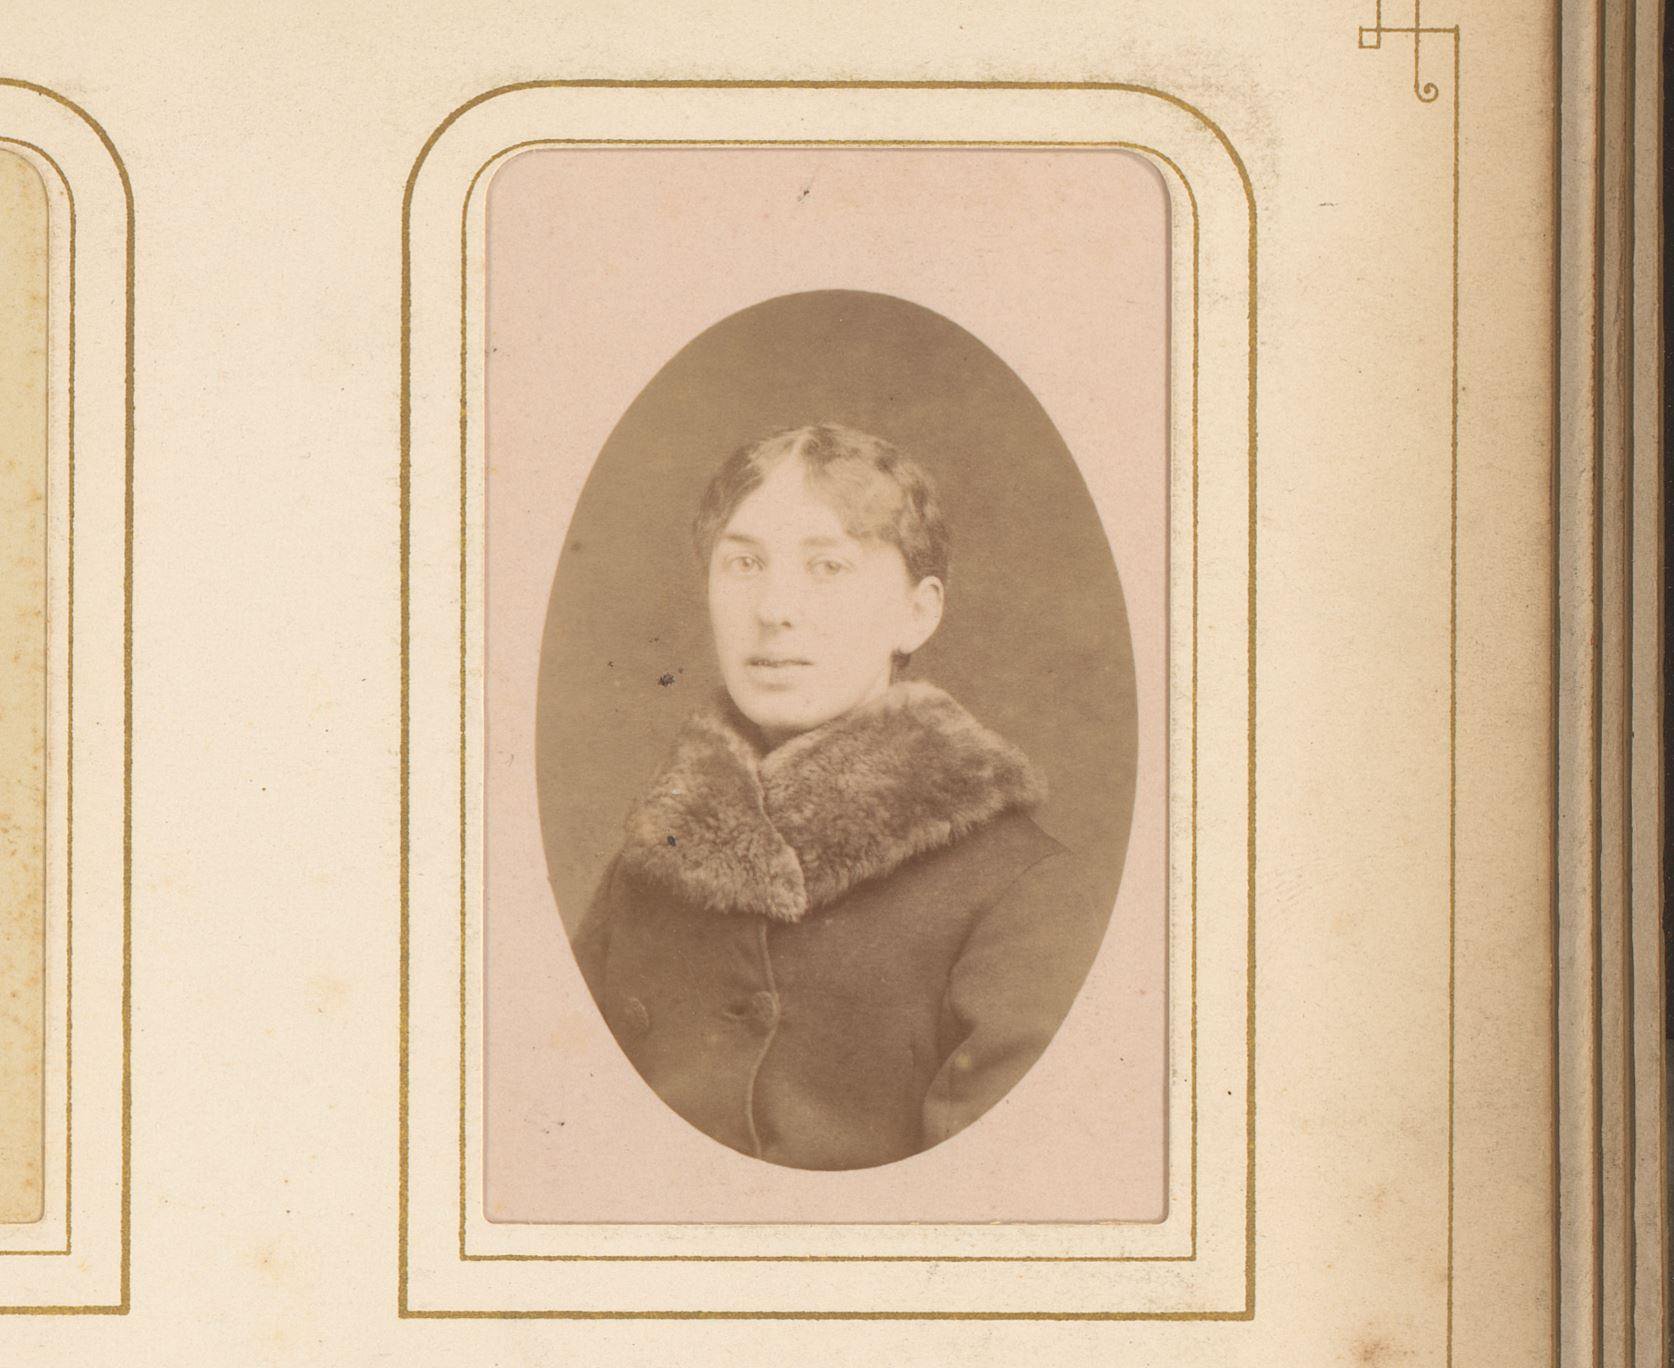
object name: carte de visite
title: Portret van een jonge vrouw in jas met bontkraag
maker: albert delabarre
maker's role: musician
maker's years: 1809-1885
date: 1874-1881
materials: cardboard, photographic support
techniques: albumen print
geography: brussels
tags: historical persons - bb - woman, coat, cape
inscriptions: inscription: ‘Photographie/ A. Delabarre/ V. Froment, Successeur/ BRUXELLES/ 18, Rue de Fossé aux Loups, 18./ (Place de la Monnaie)/ Les clichés sont conservés.’